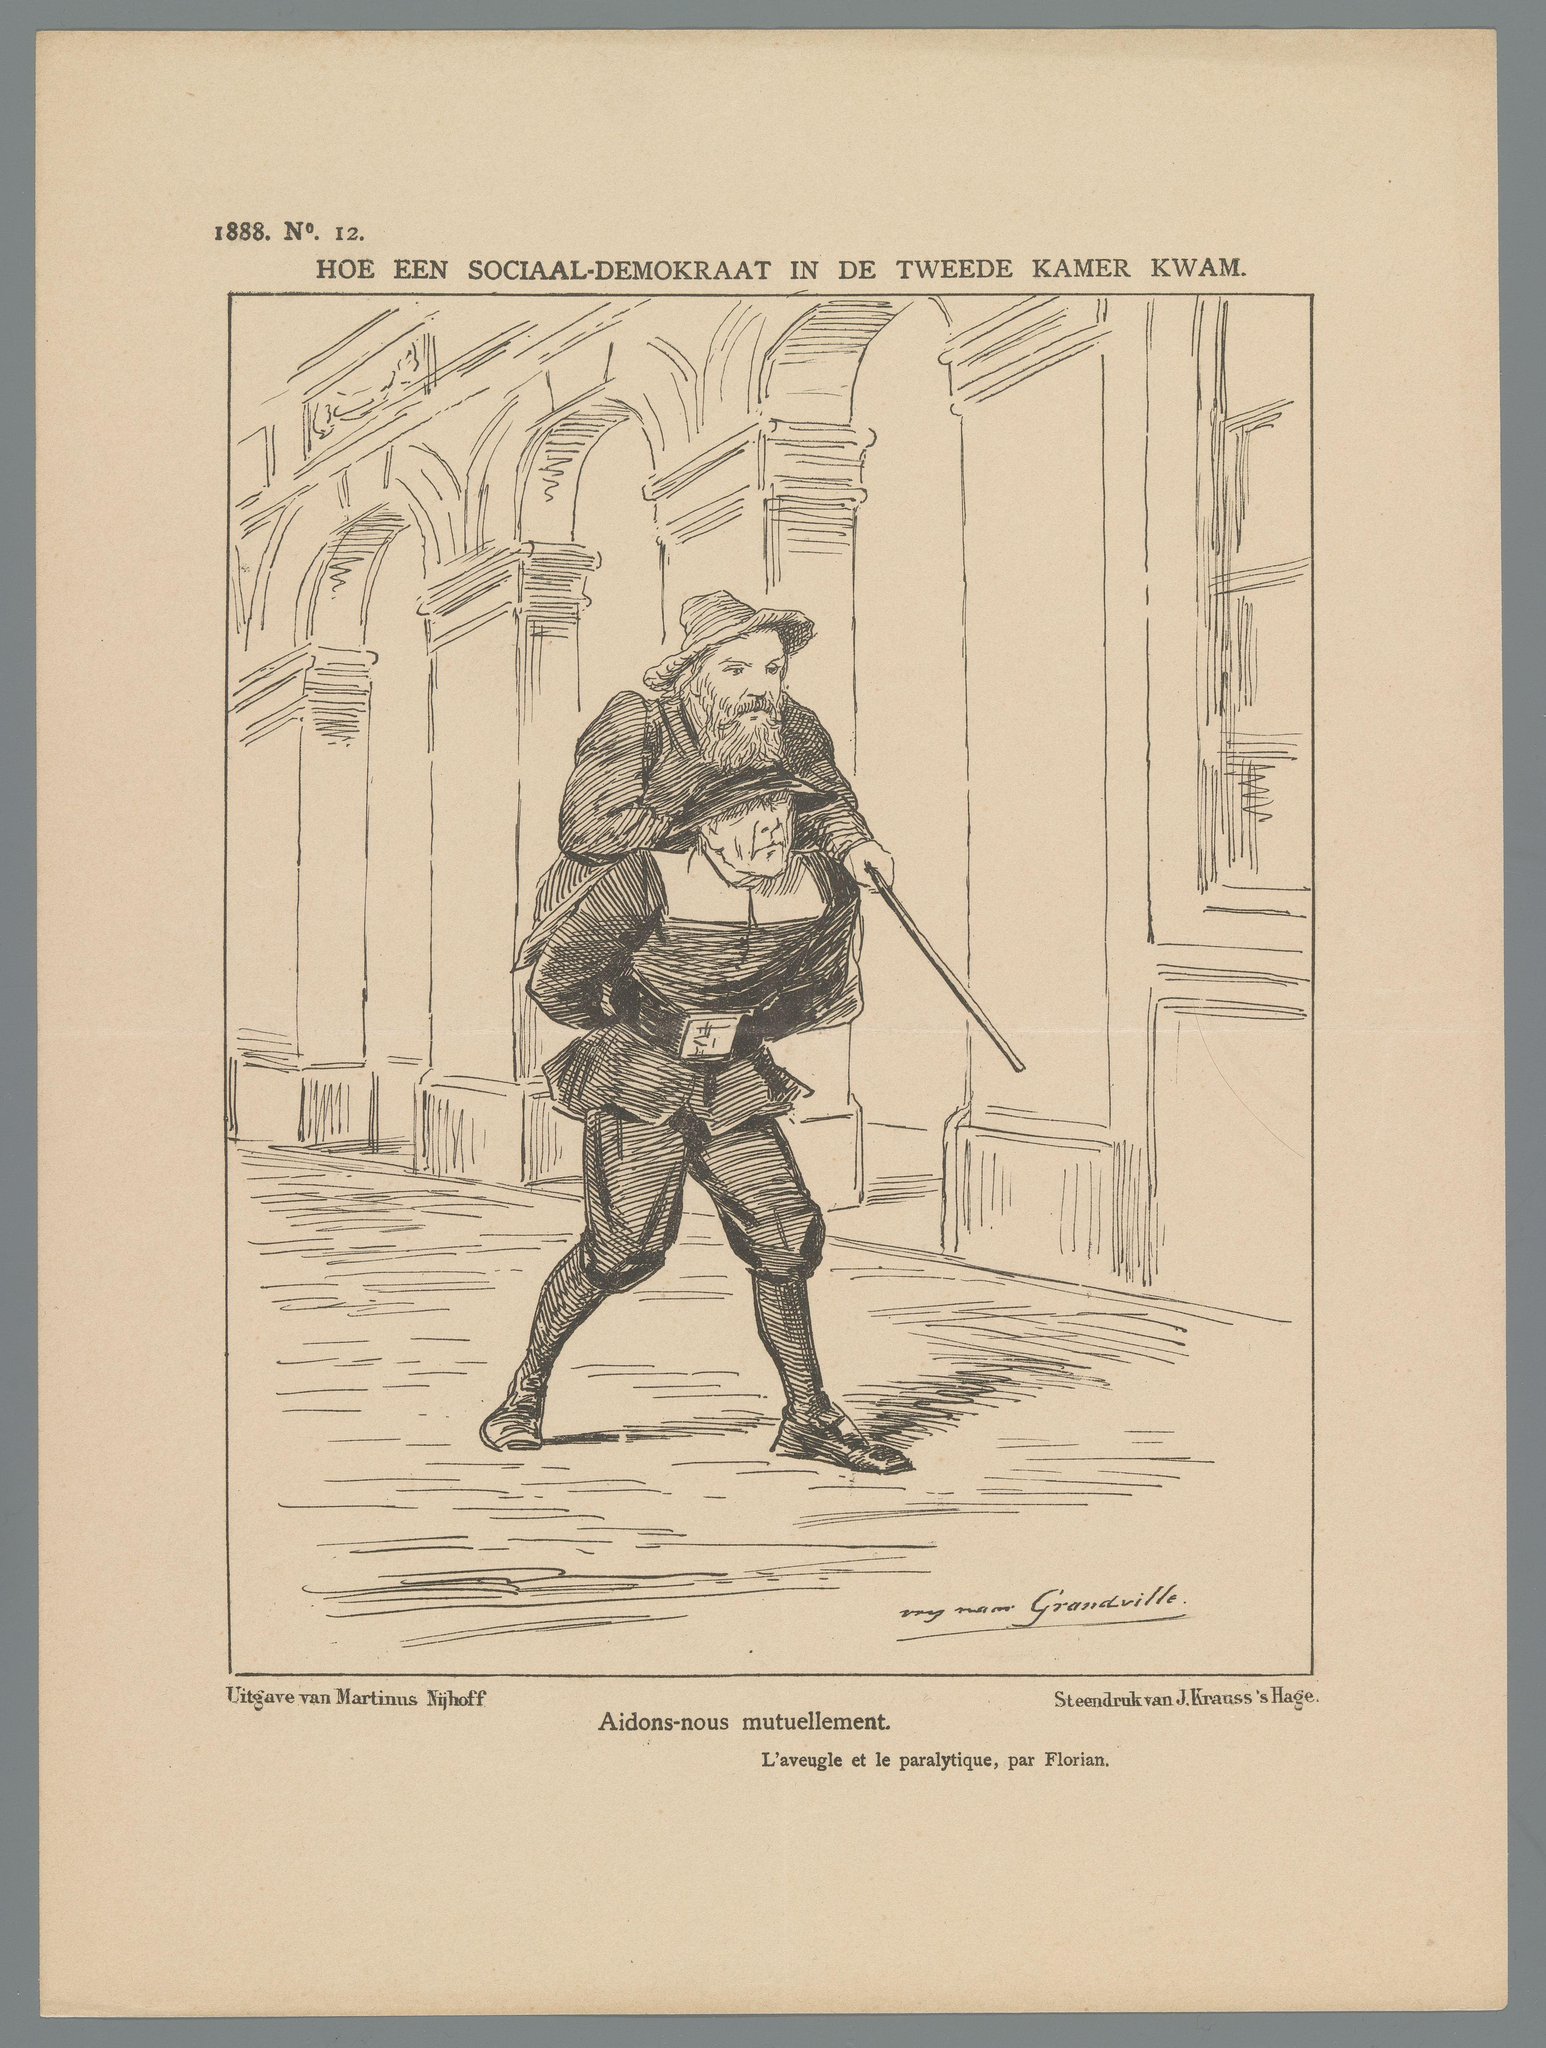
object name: cartoon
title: Hoe een sociaal-demokraat in de Tweede Kamer kwam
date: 1888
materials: paper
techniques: lithograph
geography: the hague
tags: politician, ferdinand domela nieuwenhuis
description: Spotprent hoe Ferdinand Domela Nieuwenhuis op de rug van de antirevolutionairen in de Tweede Kamer komt. Plaat verschenen bij het weekblad De Nederlandsche Spectator, nr. 12, 1888.